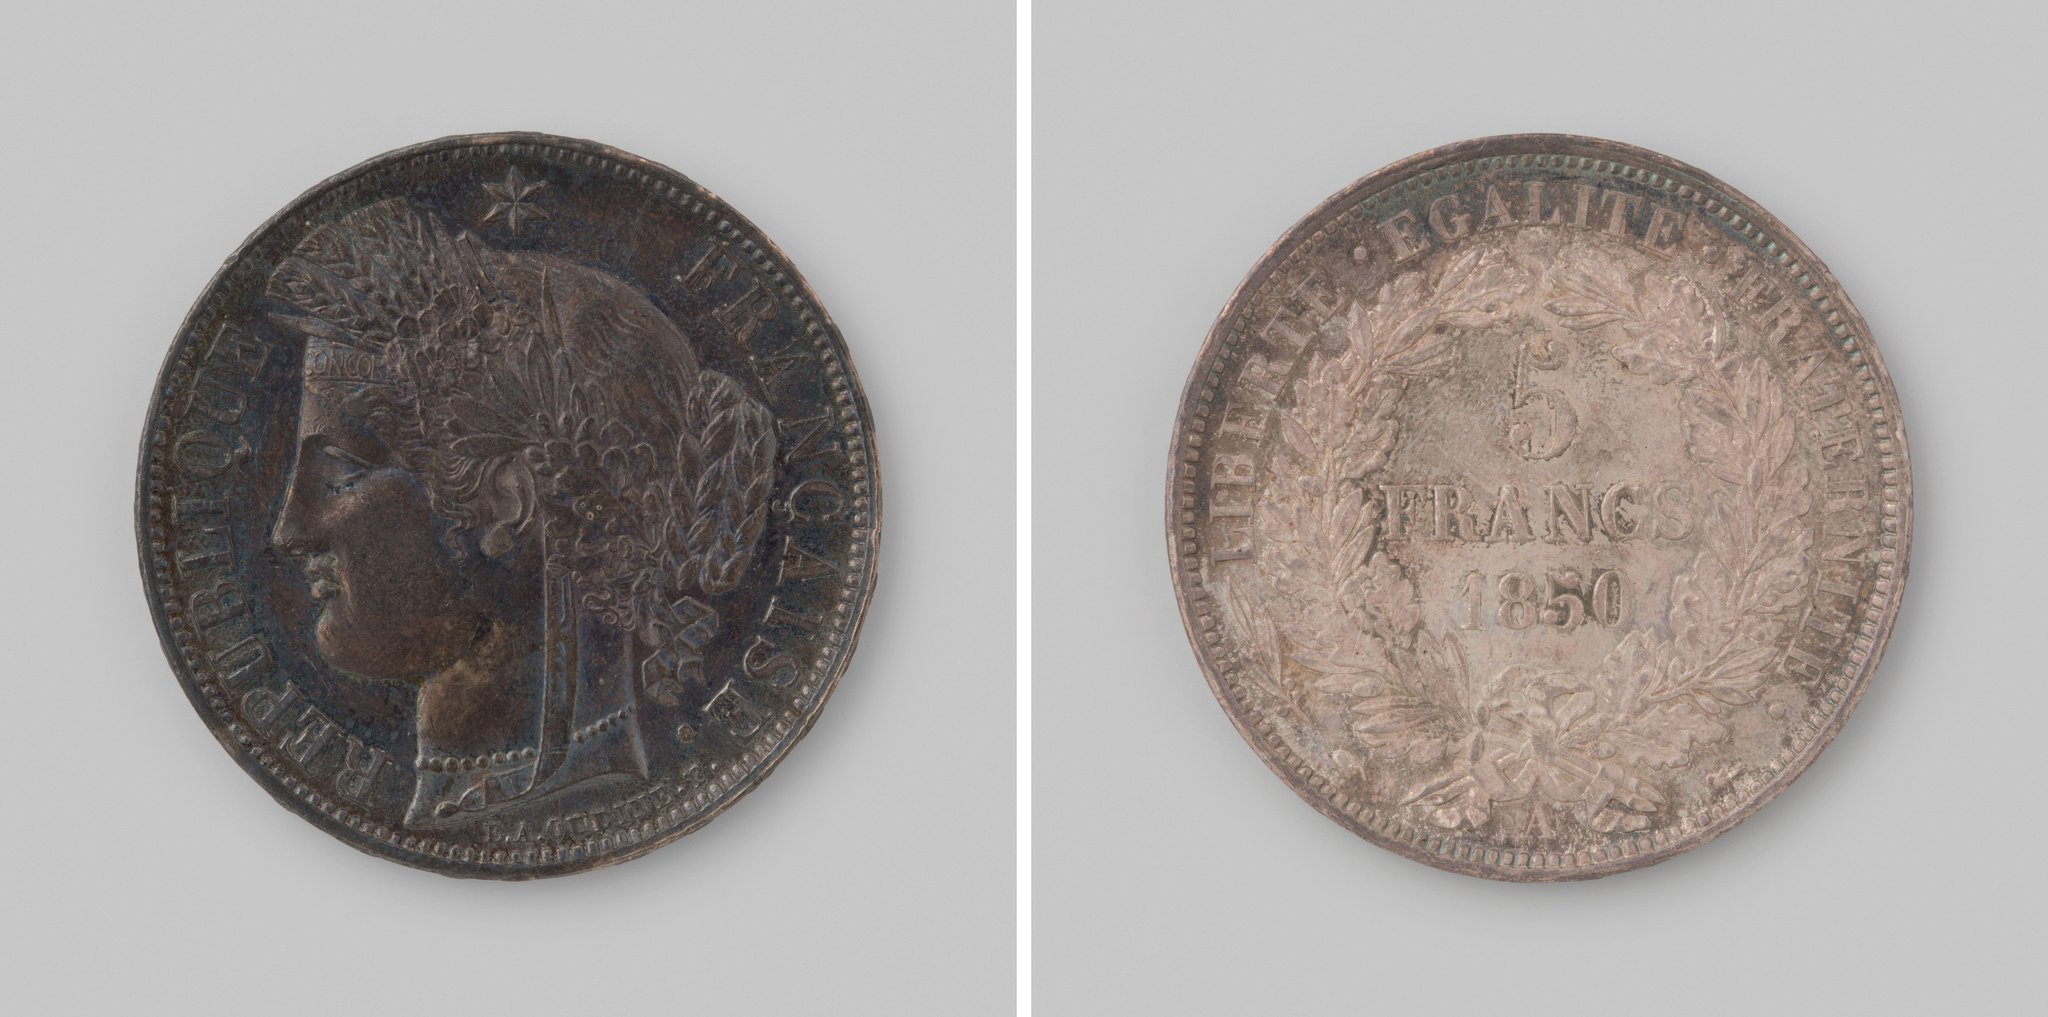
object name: coin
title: Frankrijk, Tweede Republiek, 5 francs,1850 A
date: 1850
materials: silver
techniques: striking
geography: paris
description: Zilveren munt. Voorzijde: portret van een vrouw met krans en diadeem naar links. Bovenaan ster. Keerzijde: binnen twee samengebonden takken waarde-aanduiding in twee regels, waaronder jaartal. Onderaan de letter A [=Parijs]. Opliggend randschrift.